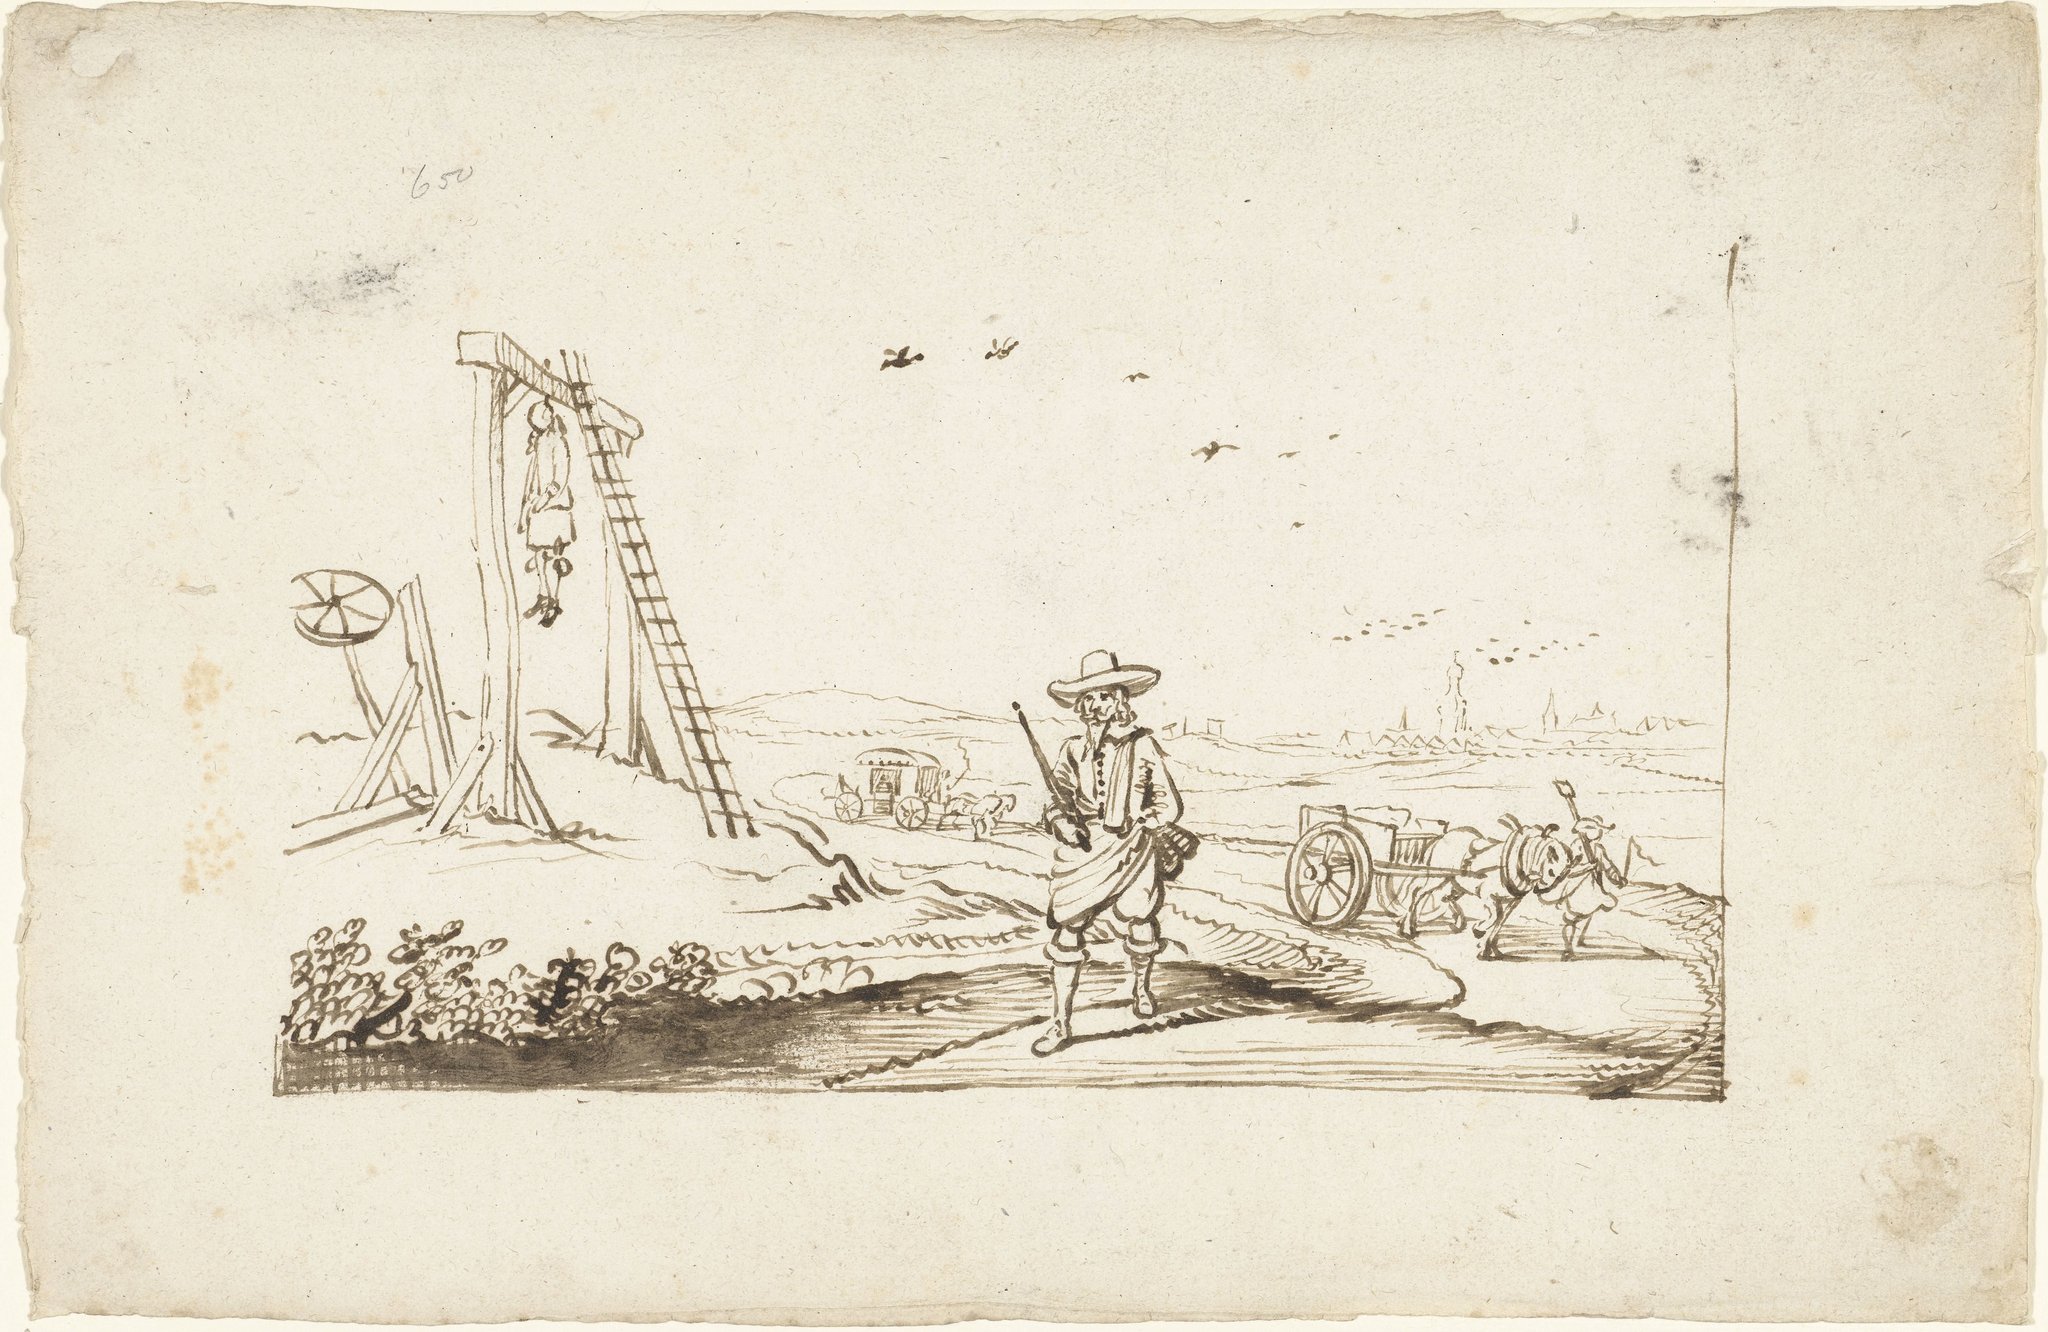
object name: drawing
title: Heer lopend op een landweg langs galgen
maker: gesina ter borch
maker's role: draughtsman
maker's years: 1633-1690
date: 1654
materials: ink, paper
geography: zwolle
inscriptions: watermark: ‘PM’